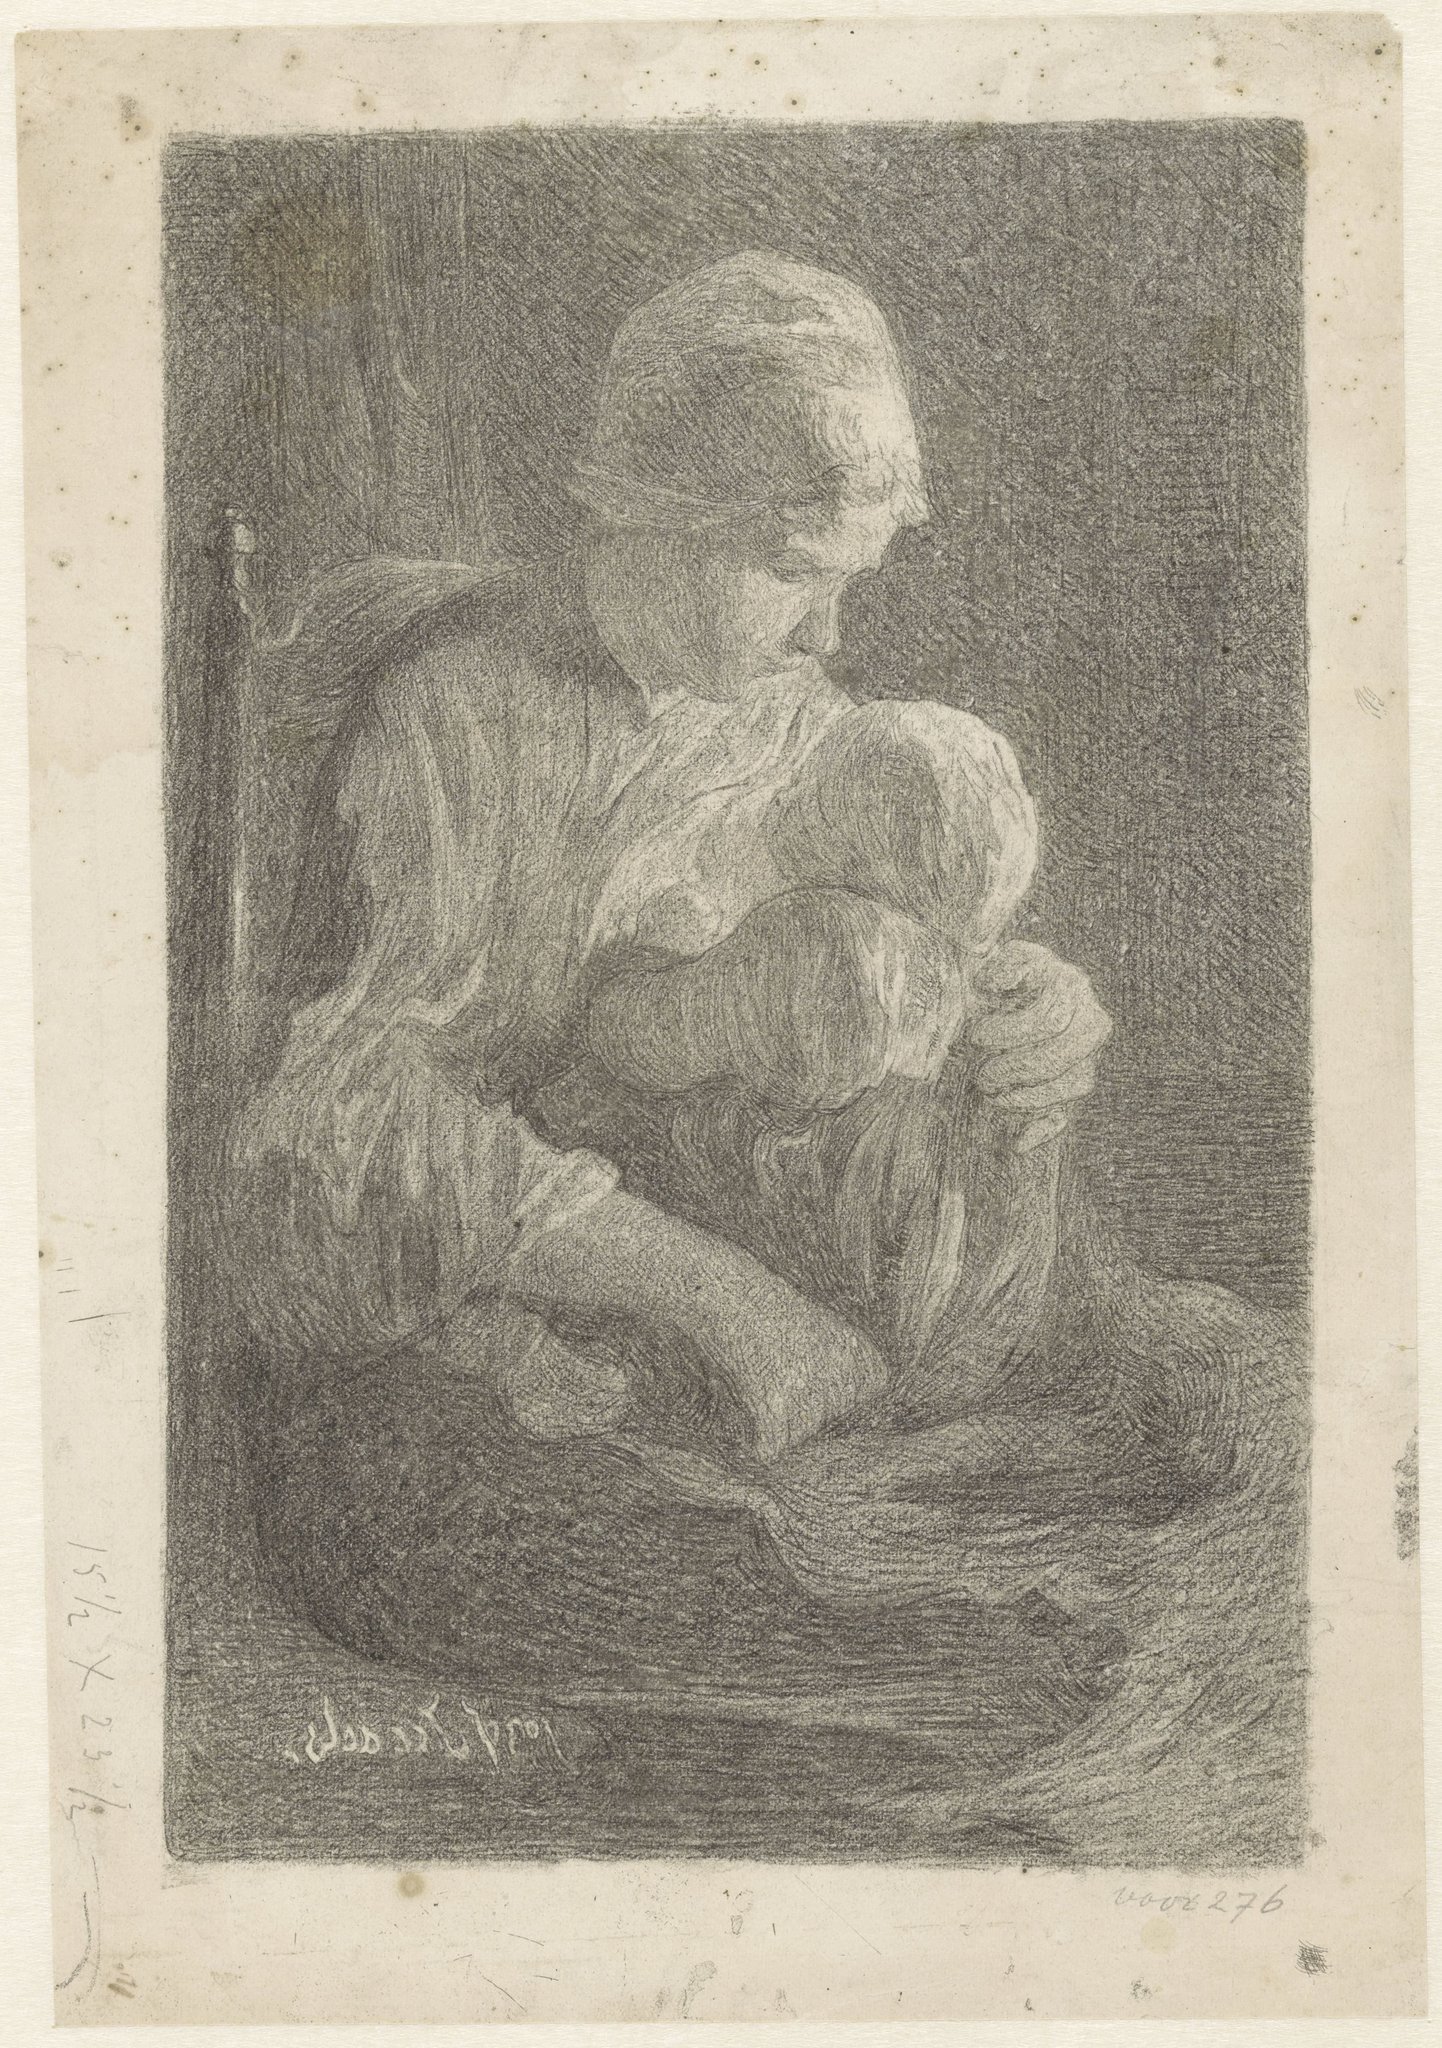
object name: drawing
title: Moeder met kind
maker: jan veth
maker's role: designer, draughtsman, painter, print maker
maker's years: 1864-1925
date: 1864-1925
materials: chalk, paper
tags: mother and baby or young child